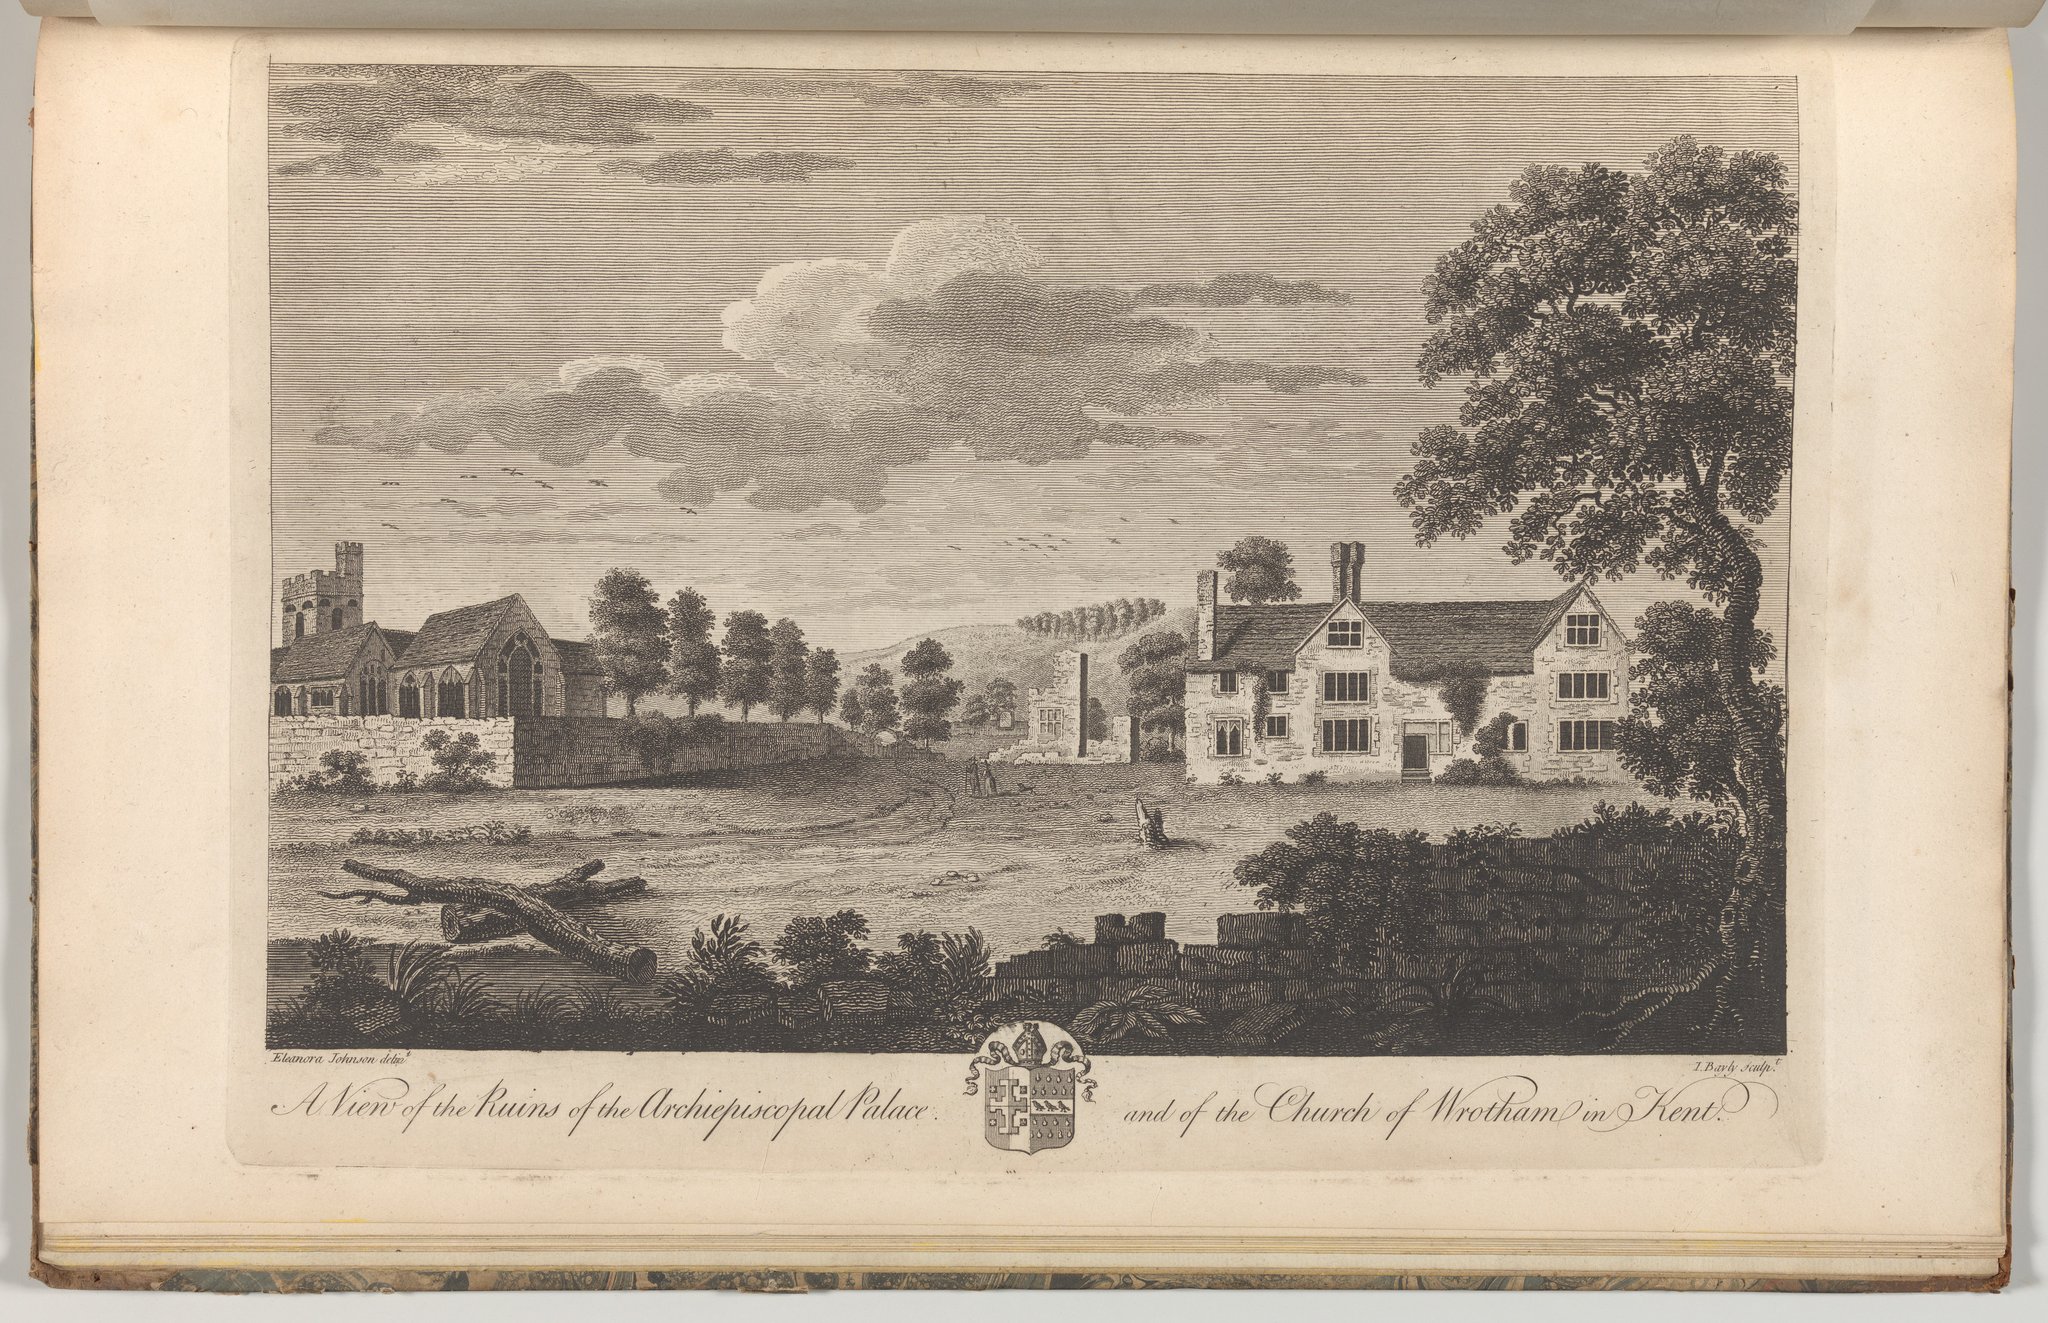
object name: print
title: A View of the Ruins of the Archiepiscopal Palace and of the Church of Wrotham in Kent, from Edward Hasted's "The History and Topographical Survey of the County of Kent", vols. 1-3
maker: john bayly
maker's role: etcher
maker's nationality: british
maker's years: 1755-1782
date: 1777-1790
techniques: engraving, etching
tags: palaces,churches,ruins